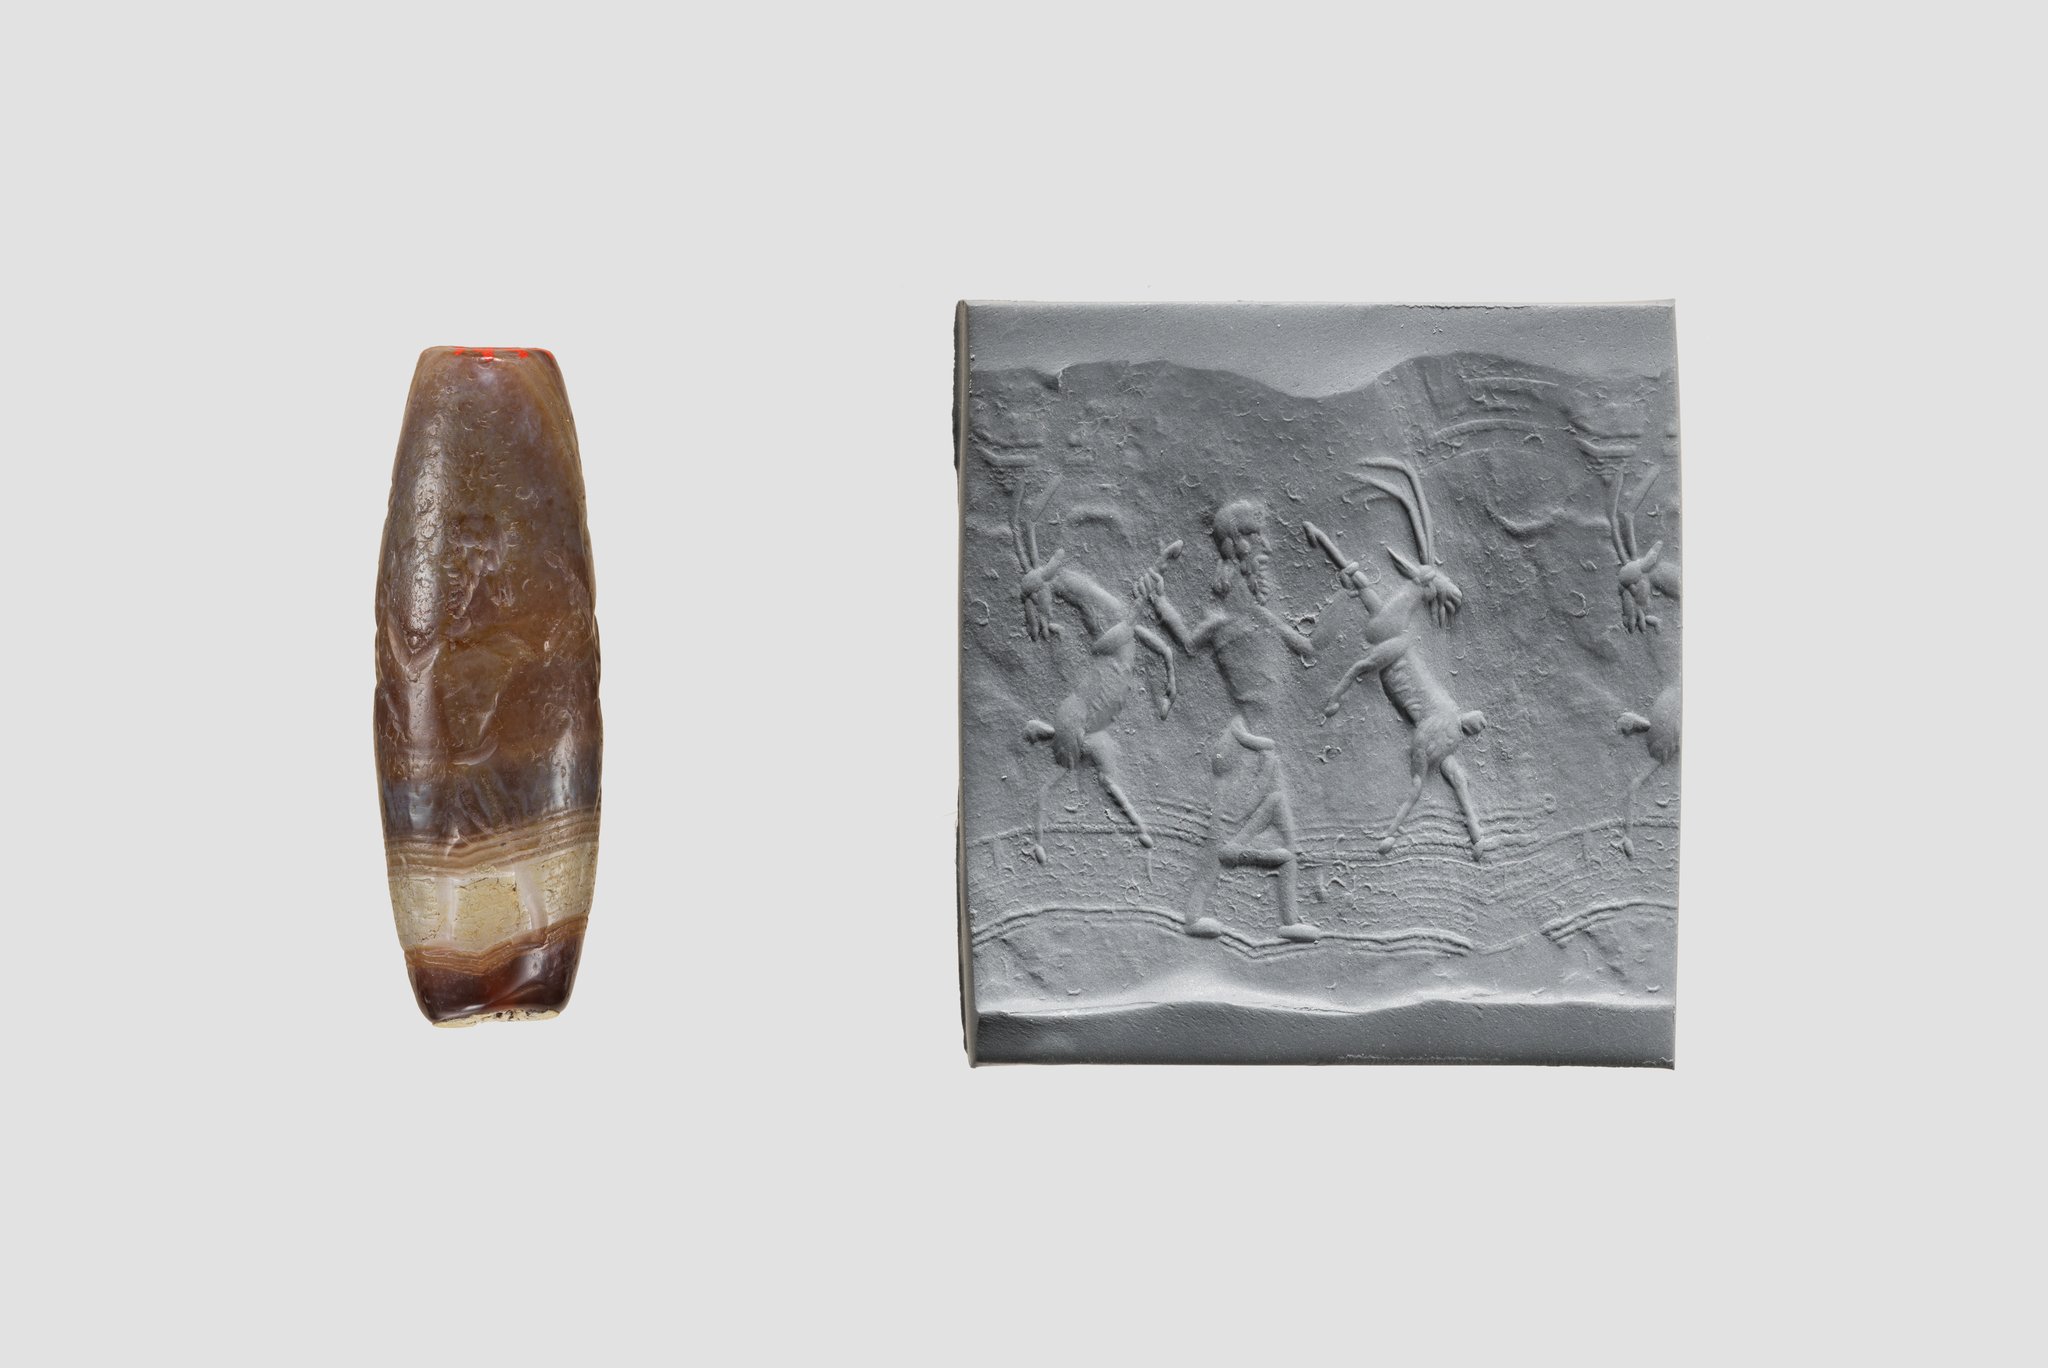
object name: cylinder seal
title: Cylinder seal with three-figure contest scene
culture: achaemenid or babylonian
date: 834-501 BCE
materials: stone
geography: mesopotamia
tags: animals